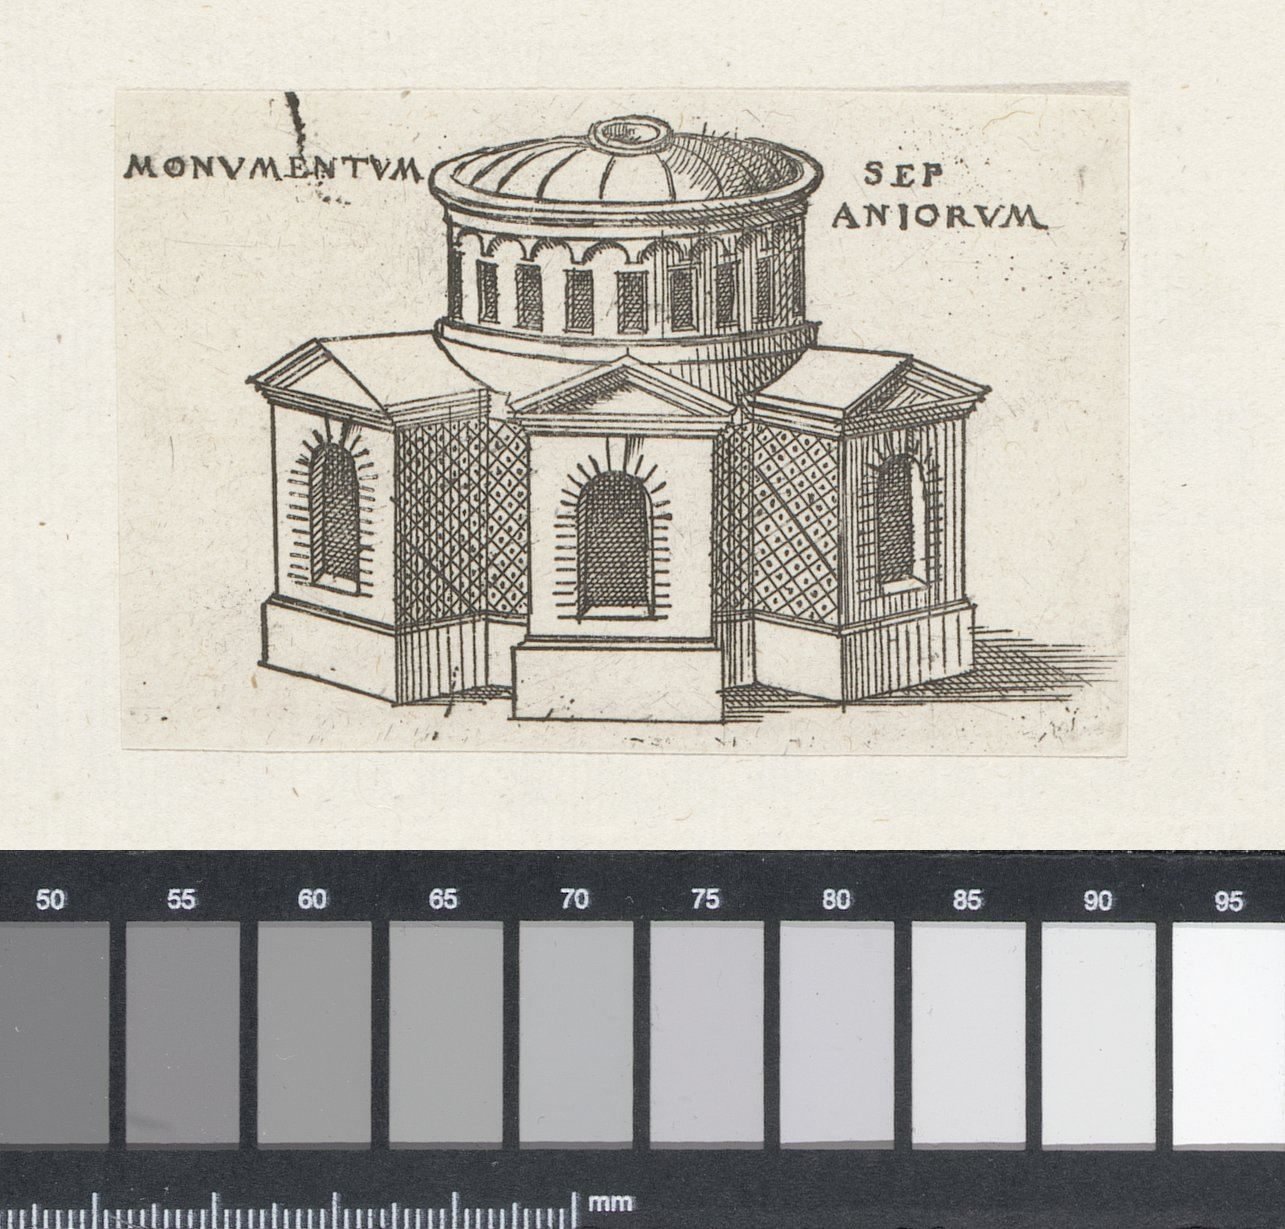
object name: album leaf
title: Monumentum Sepaniorum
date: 1584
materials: paper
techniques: etching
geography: france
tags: representation of real building (either existing or having existed)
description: Deze prent maakt deel uit van een serie van 98 prenten gedrukt op 48 bladen. De bladen zijn verknipt en een selectie van de losse prenten is in dit album geplakt.